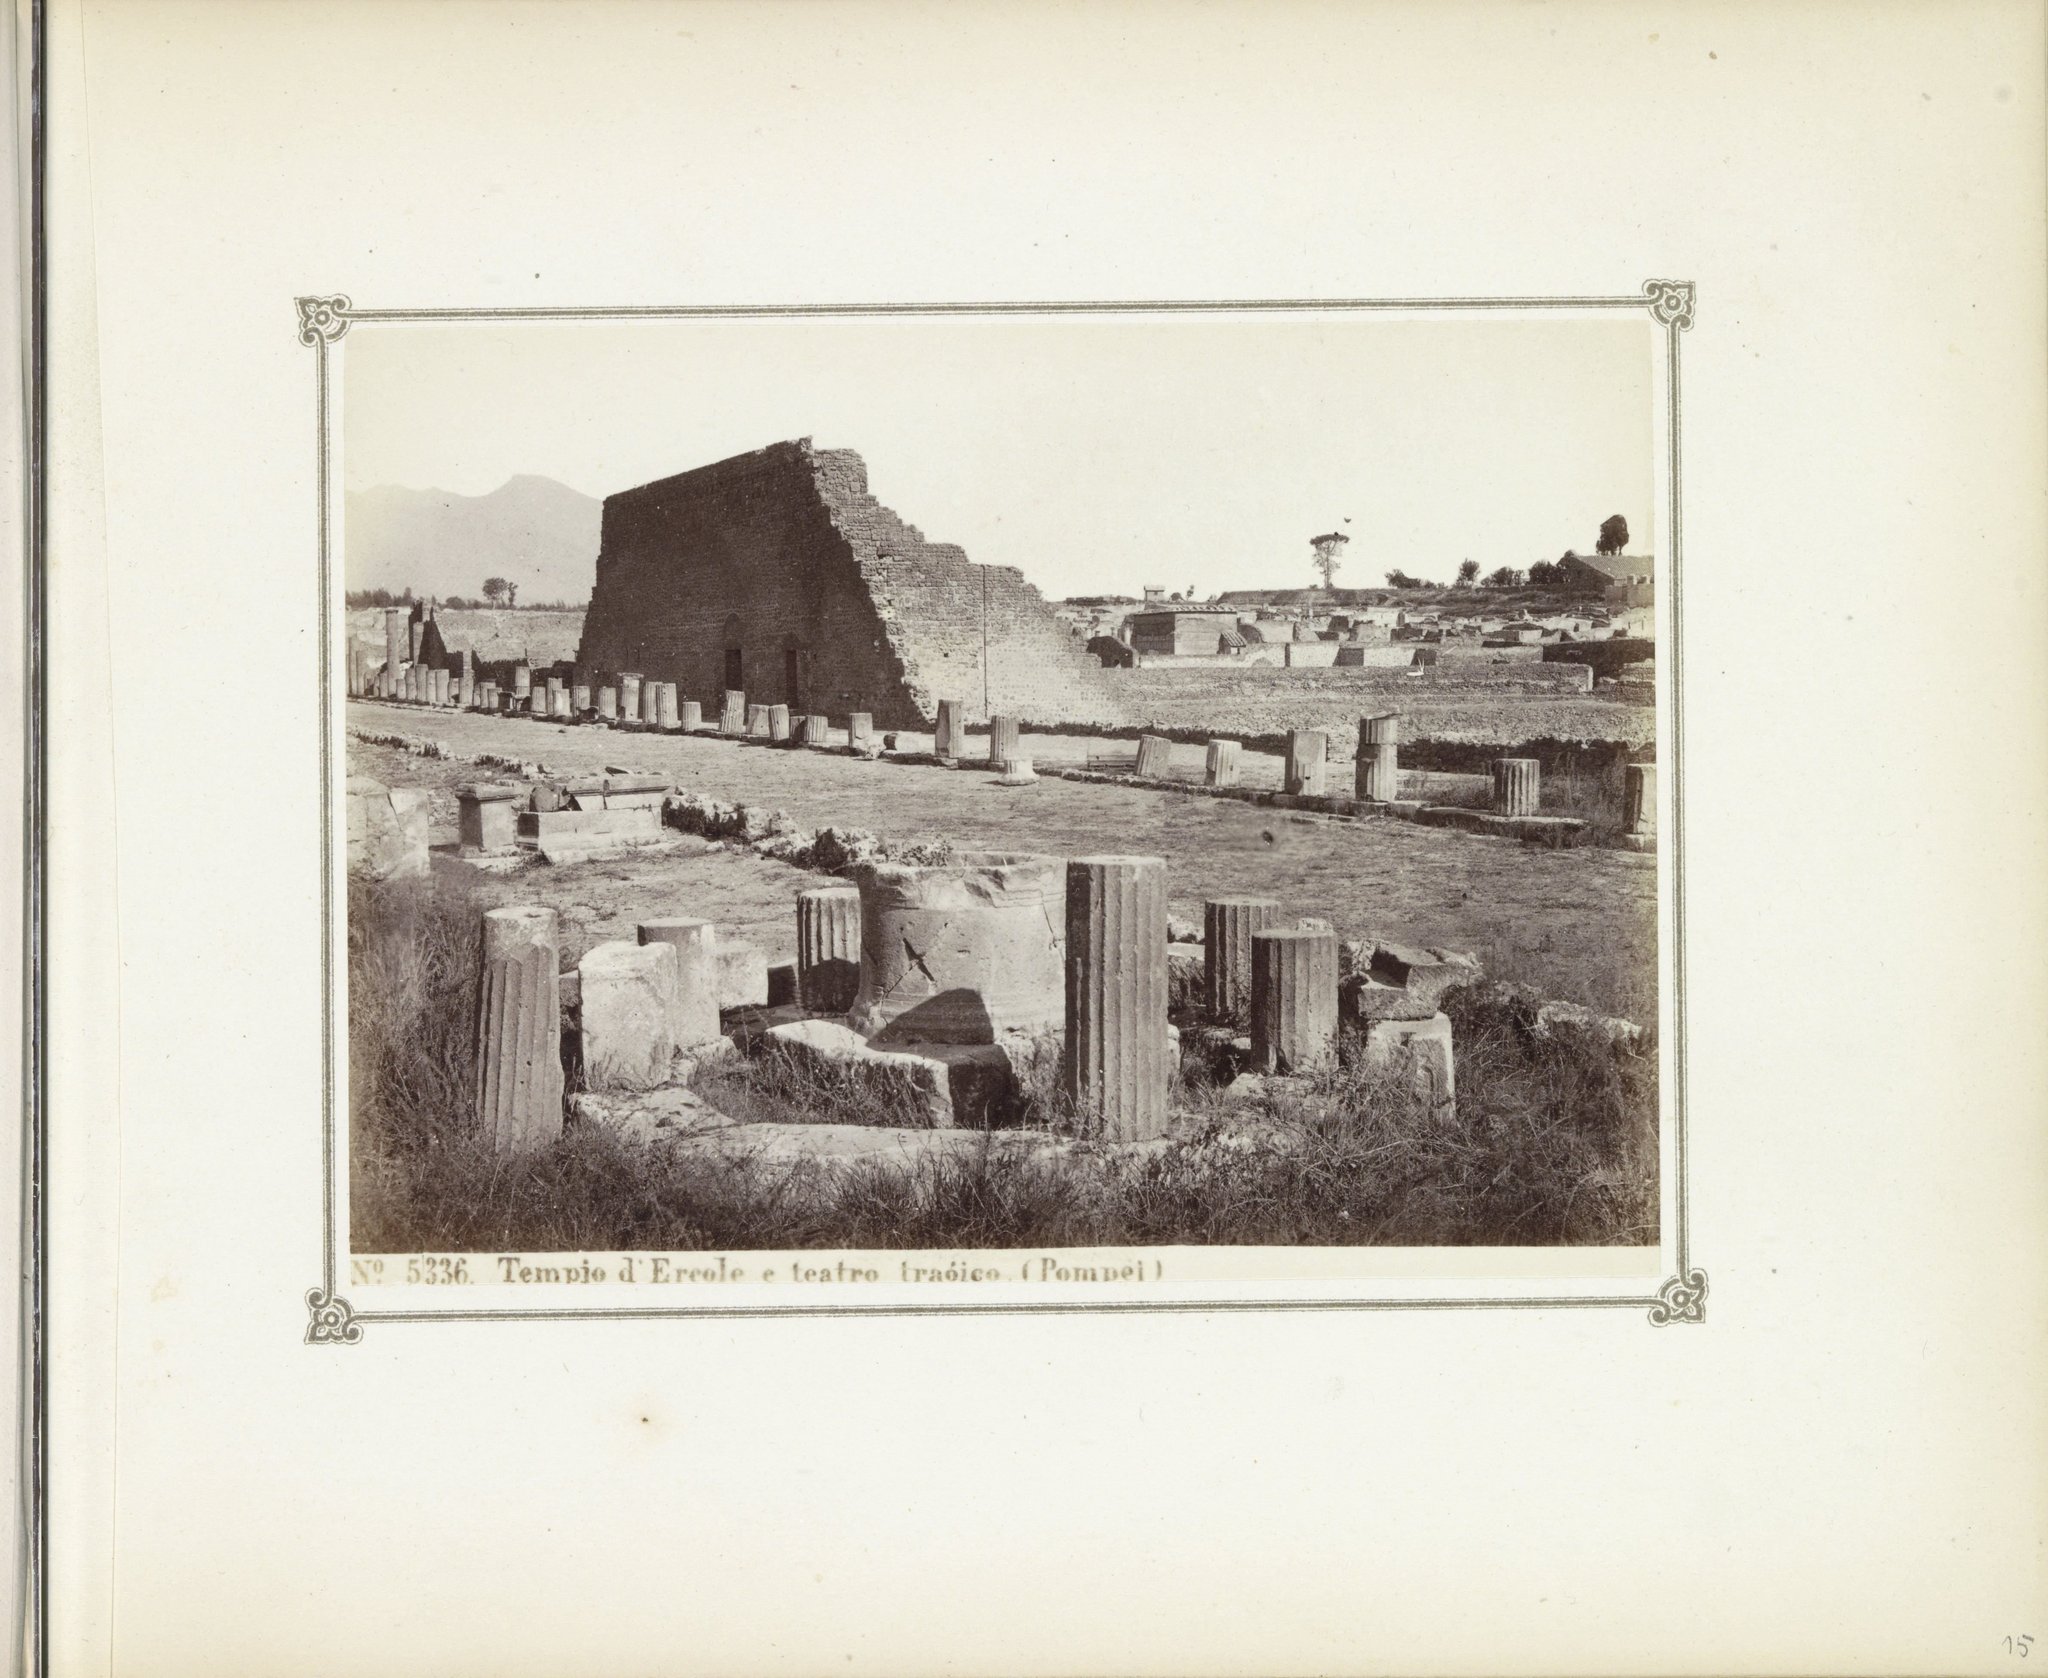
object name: photograph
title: Restanten van de tempel van Hercules en een theater in Pompeï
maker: giorgio sommer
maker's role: fotograaf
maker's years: 1834-1914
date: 1860-1900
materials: paper, photographic support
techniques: albumen print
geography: pompeii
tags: theatre (building), temple, shrine ~ roman religion, excavation ~ archaeology, pompeii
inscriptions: number: ‘5336’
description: Onderdeel van Fotoalbum met opnames van opgravingen in Pompeï door Giorgio Sommer.